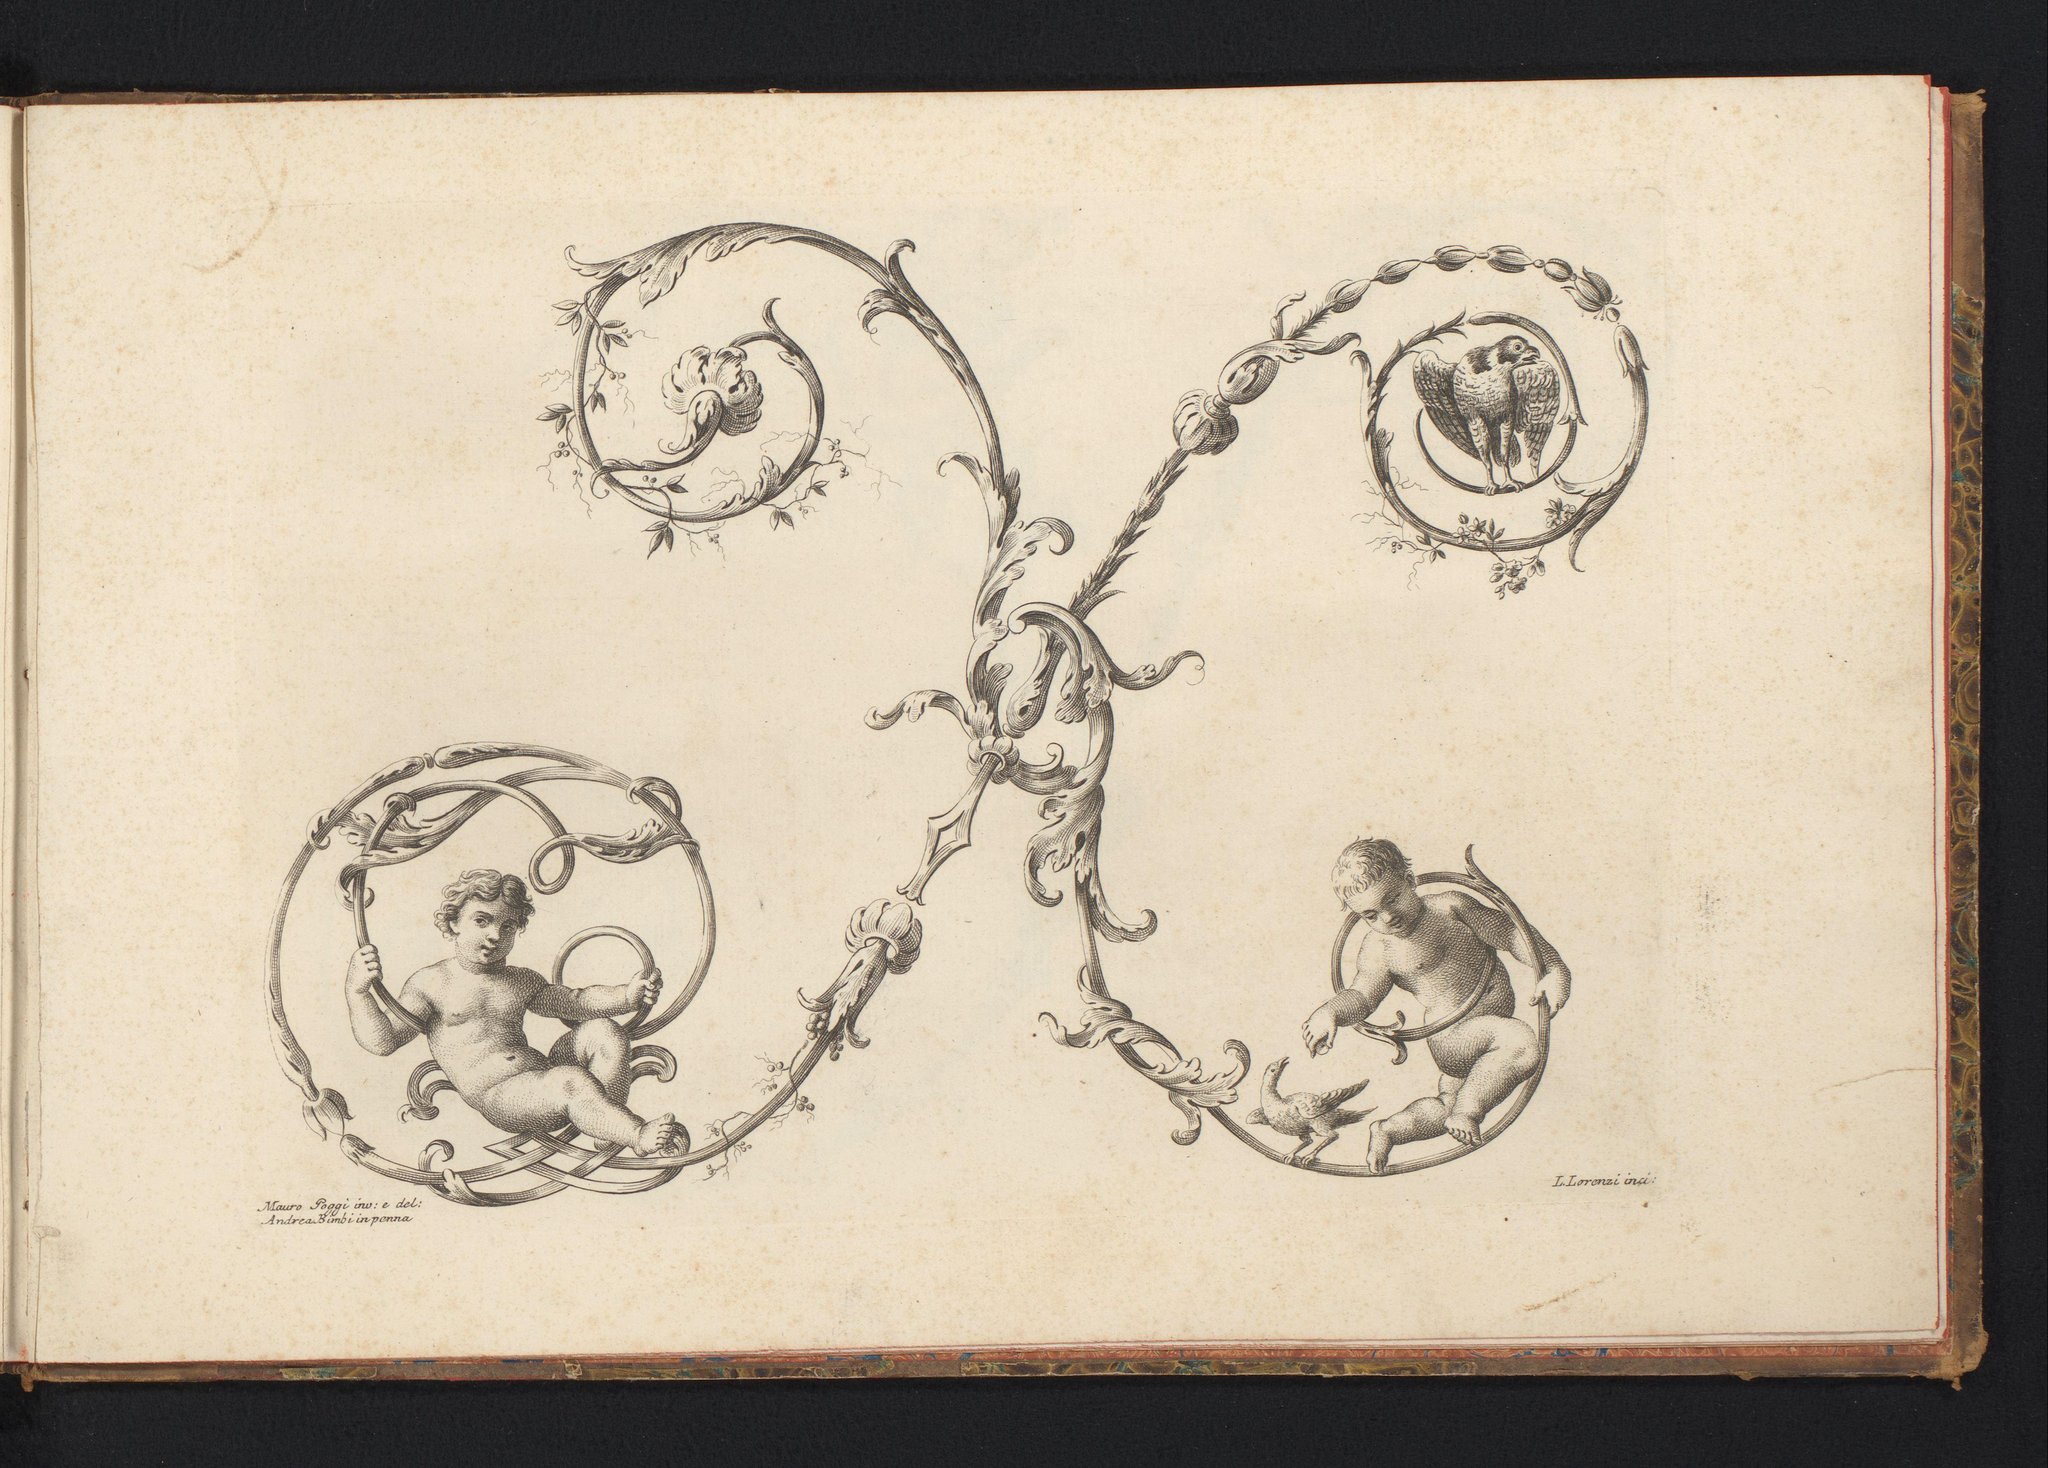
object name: print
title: Ornamentele letter X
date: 1745-1765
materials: paper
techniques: engraving, etching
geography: italy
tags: letters, alphabet, script, fancy letters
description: Ornamentele letter X, versierd met een vogel en twee naakte jongens. Prent maakt deel uit van een album.